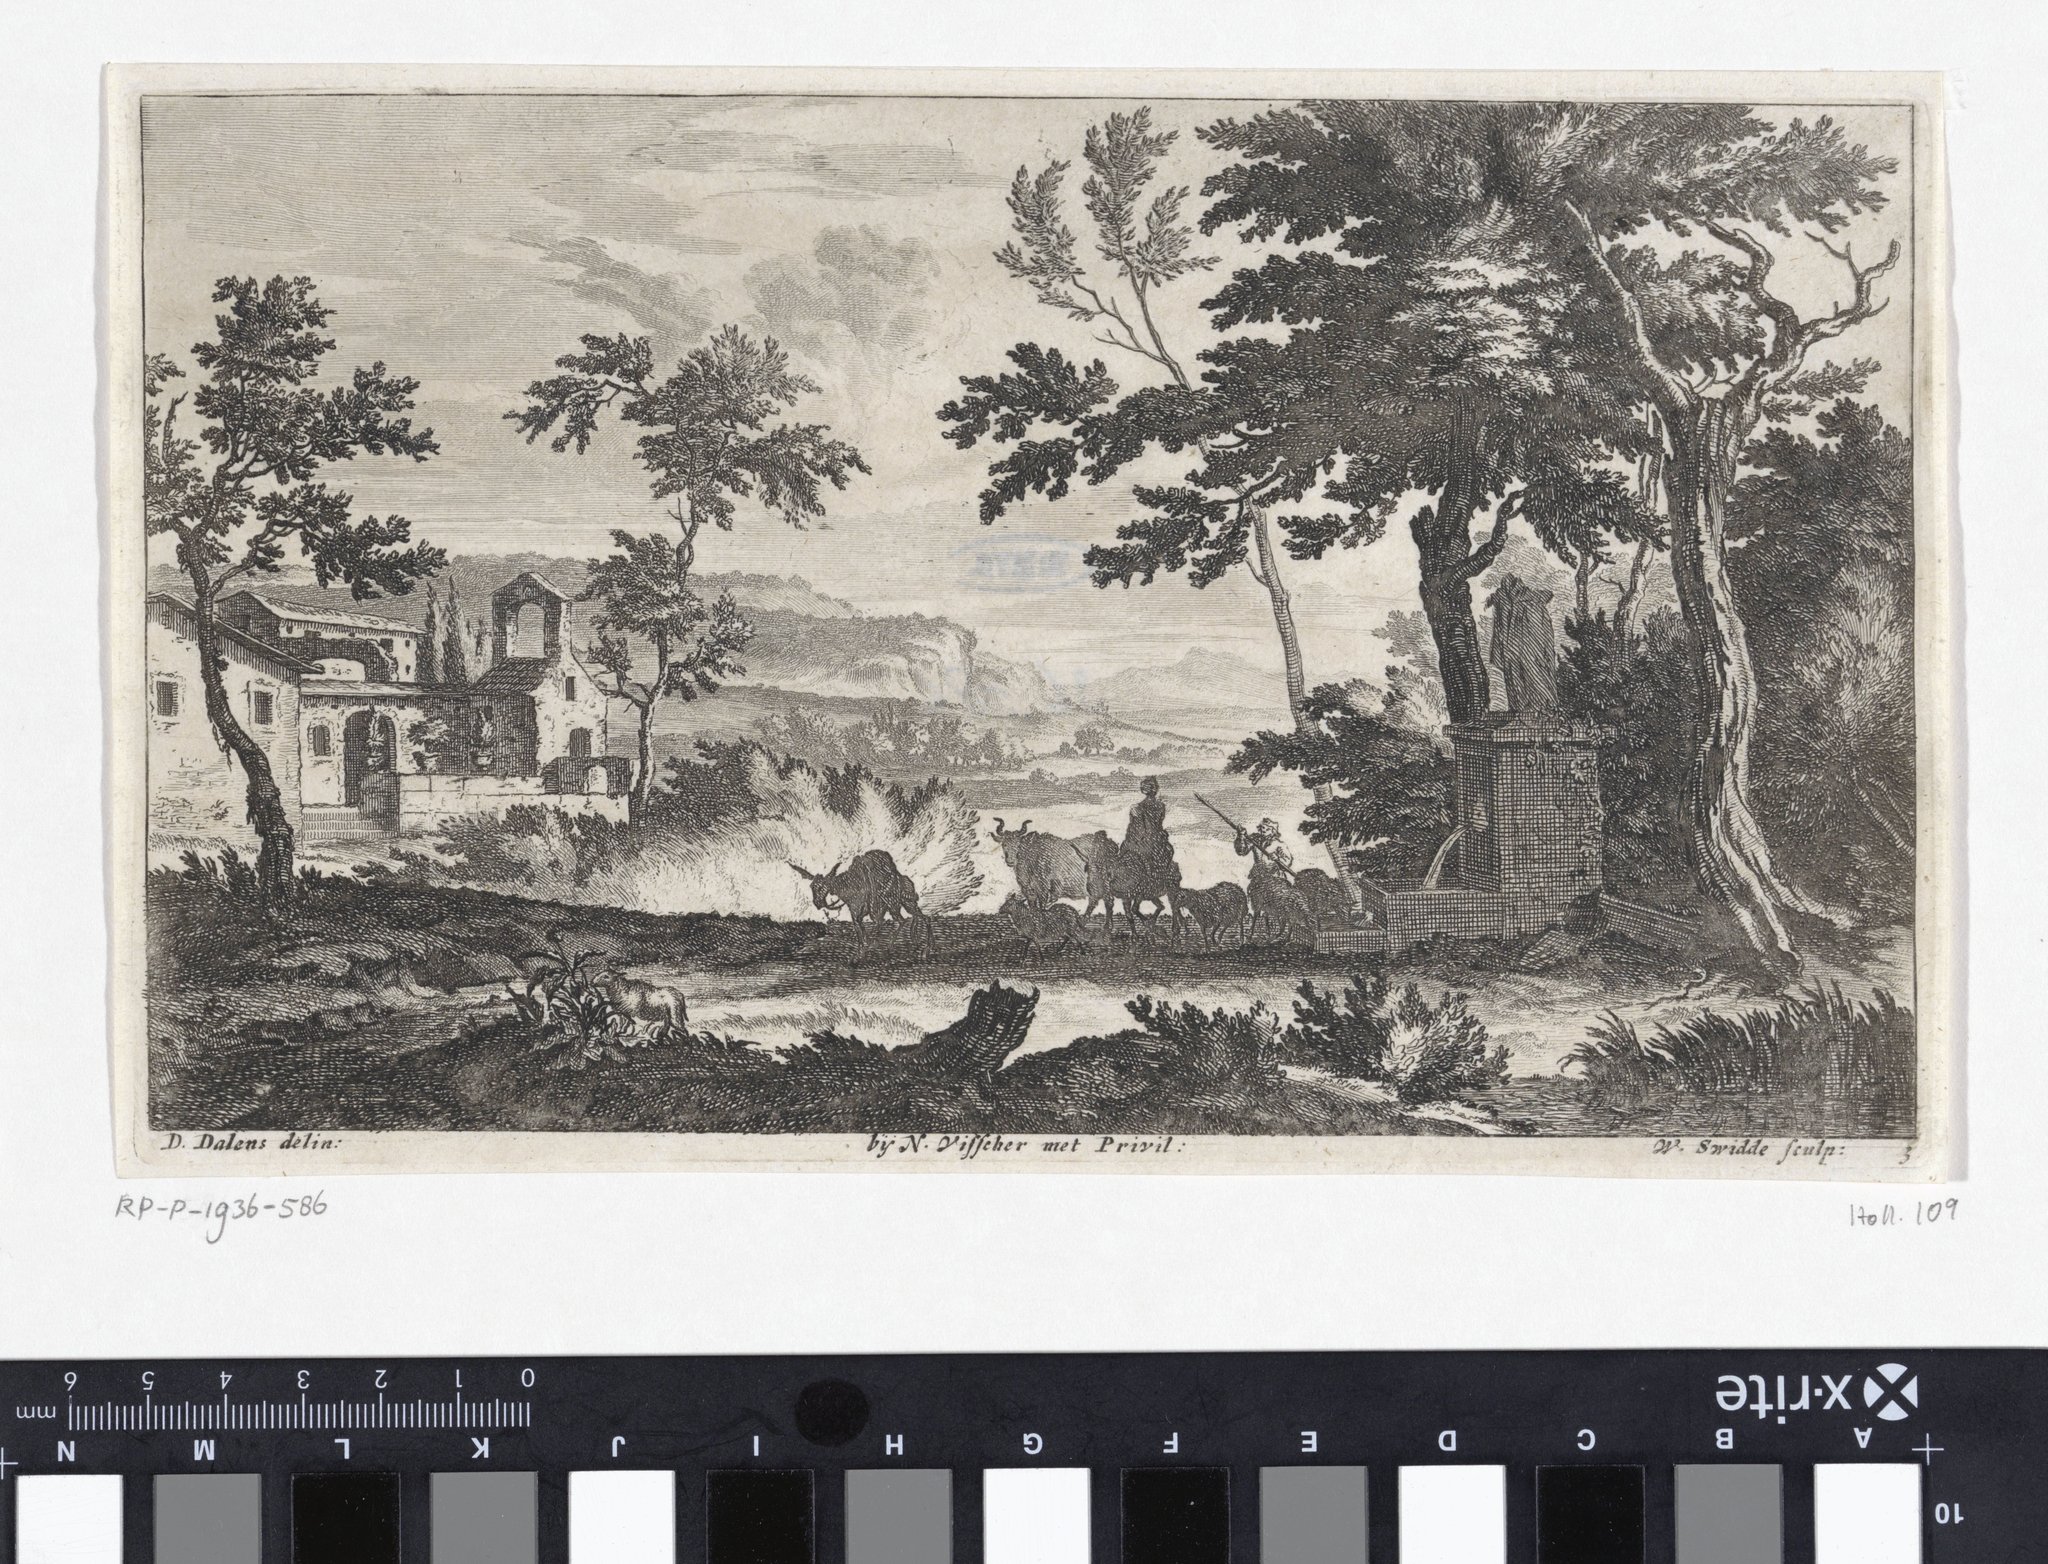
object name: print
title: Landschap met waterbron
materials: paper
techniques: etching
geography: amsterdam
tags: abbey, monastery, convent ~ roman catholic church, ornamental fountain, landscapes - hh - ideal landscapes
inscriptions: collector's mark: Lugt 2228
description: Een herder en herderin voeren hun kudde langs een waterbron met standbeeld op een heuveltop. Links een klooster.